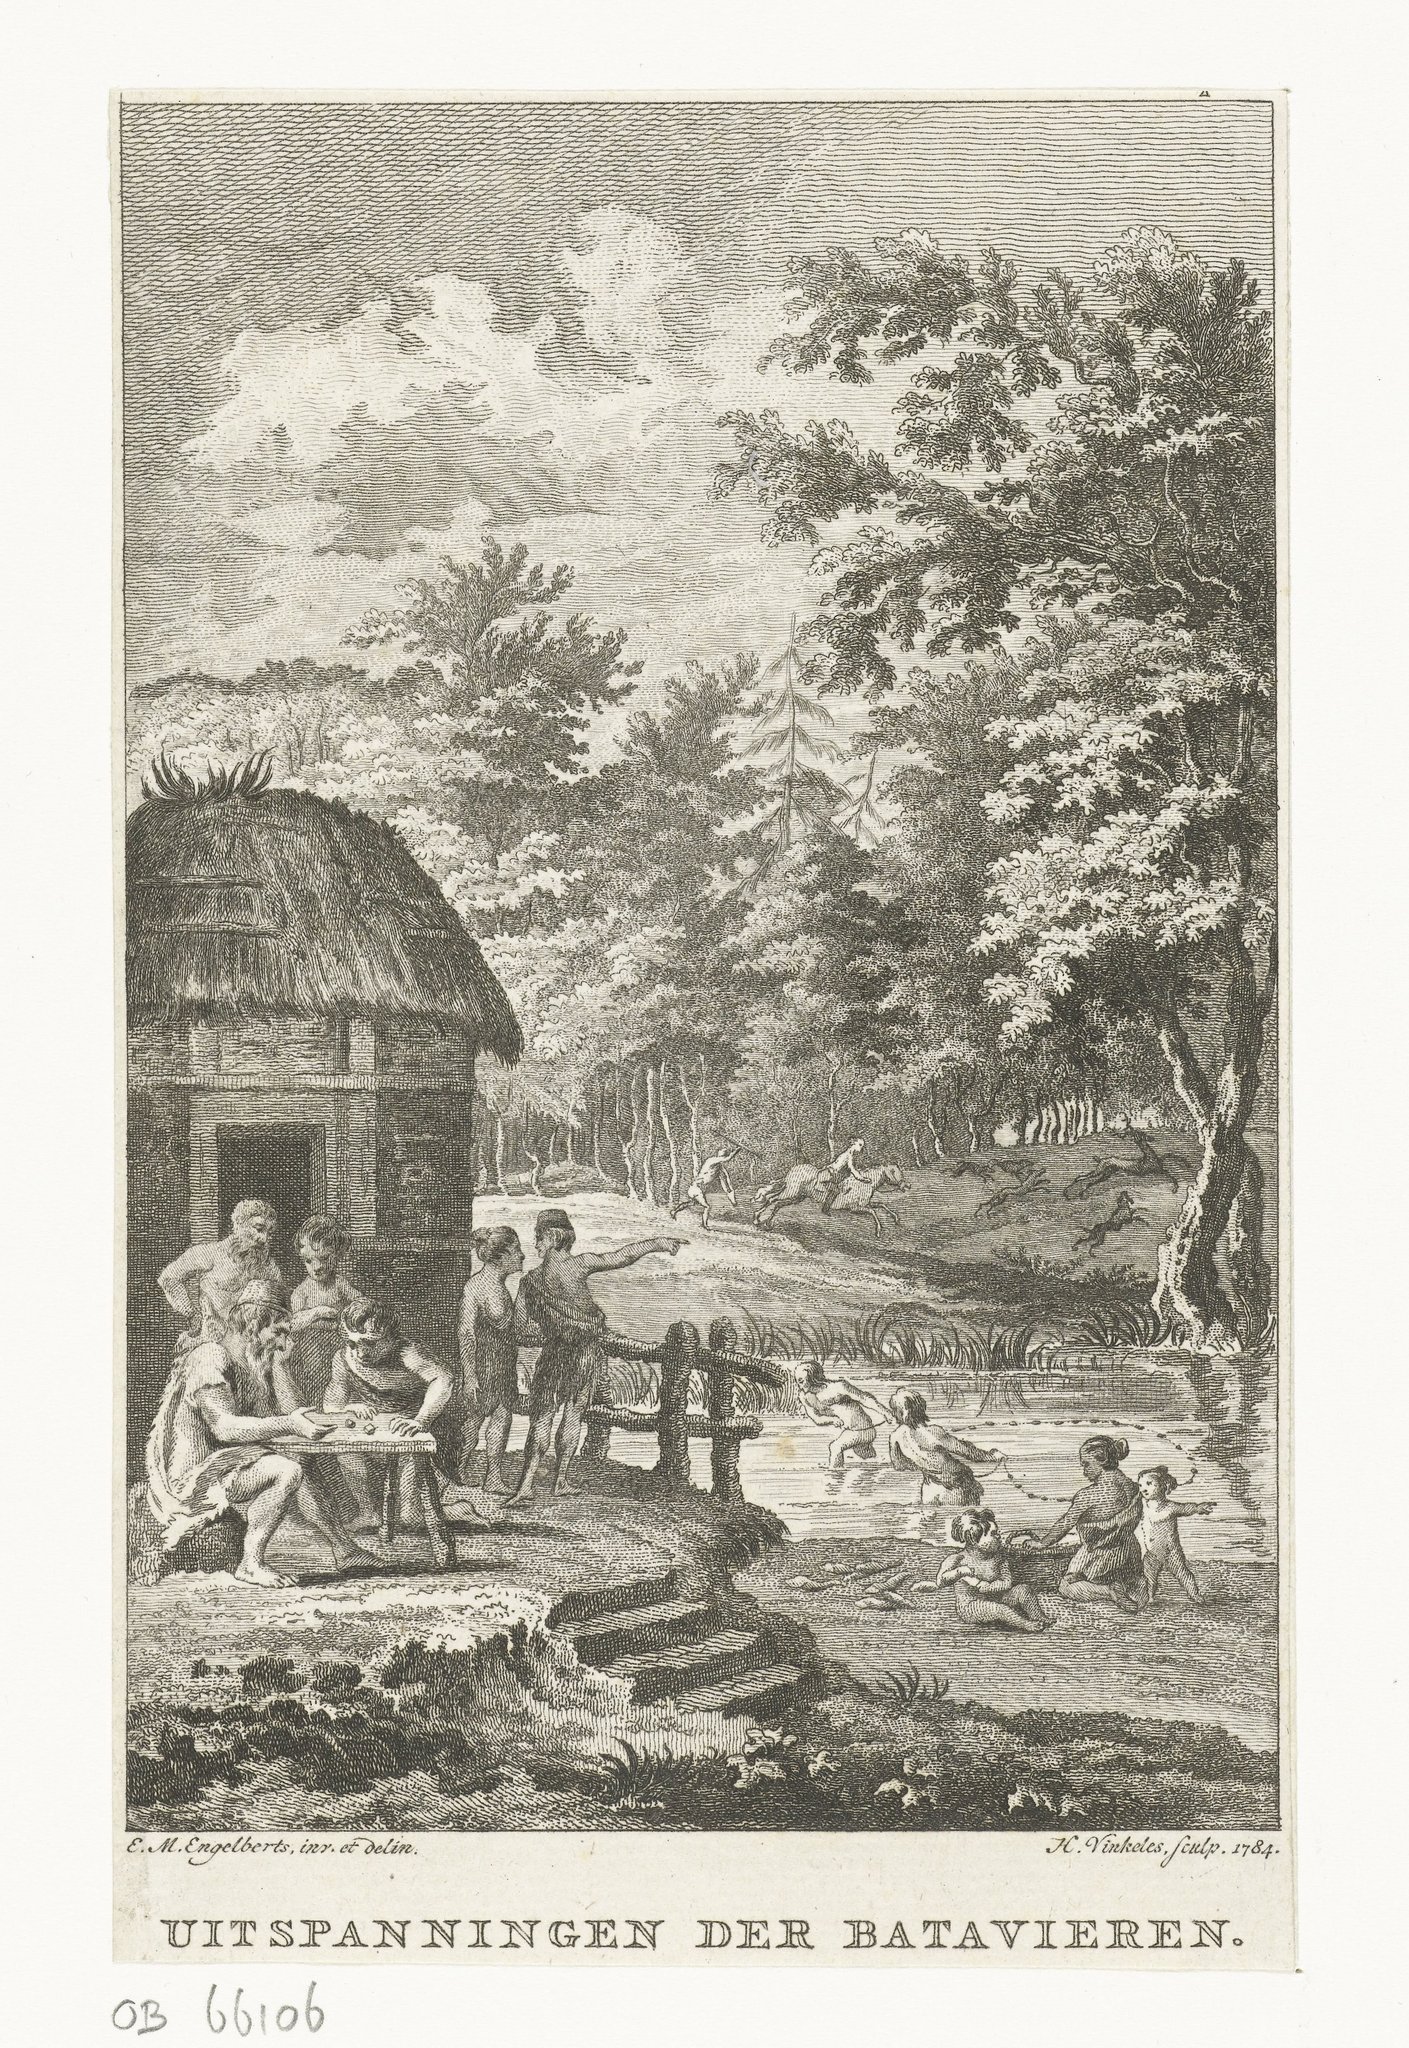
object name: history print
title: Jacht, visserij en ontspanning bij de Bataven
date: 1784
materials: paper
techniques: etching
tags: extinct, 'historical' peoples (with name), netherlands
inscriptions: collector's mark: Lugt 2228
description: Prent gebruikt als boekillustratie in: Engelberts, Engelbertus Matthias. De aloude staat en geschiedenissen der Vereenigde Nederlanden. Amsterdam: Johannes Allart, 1784-1799.